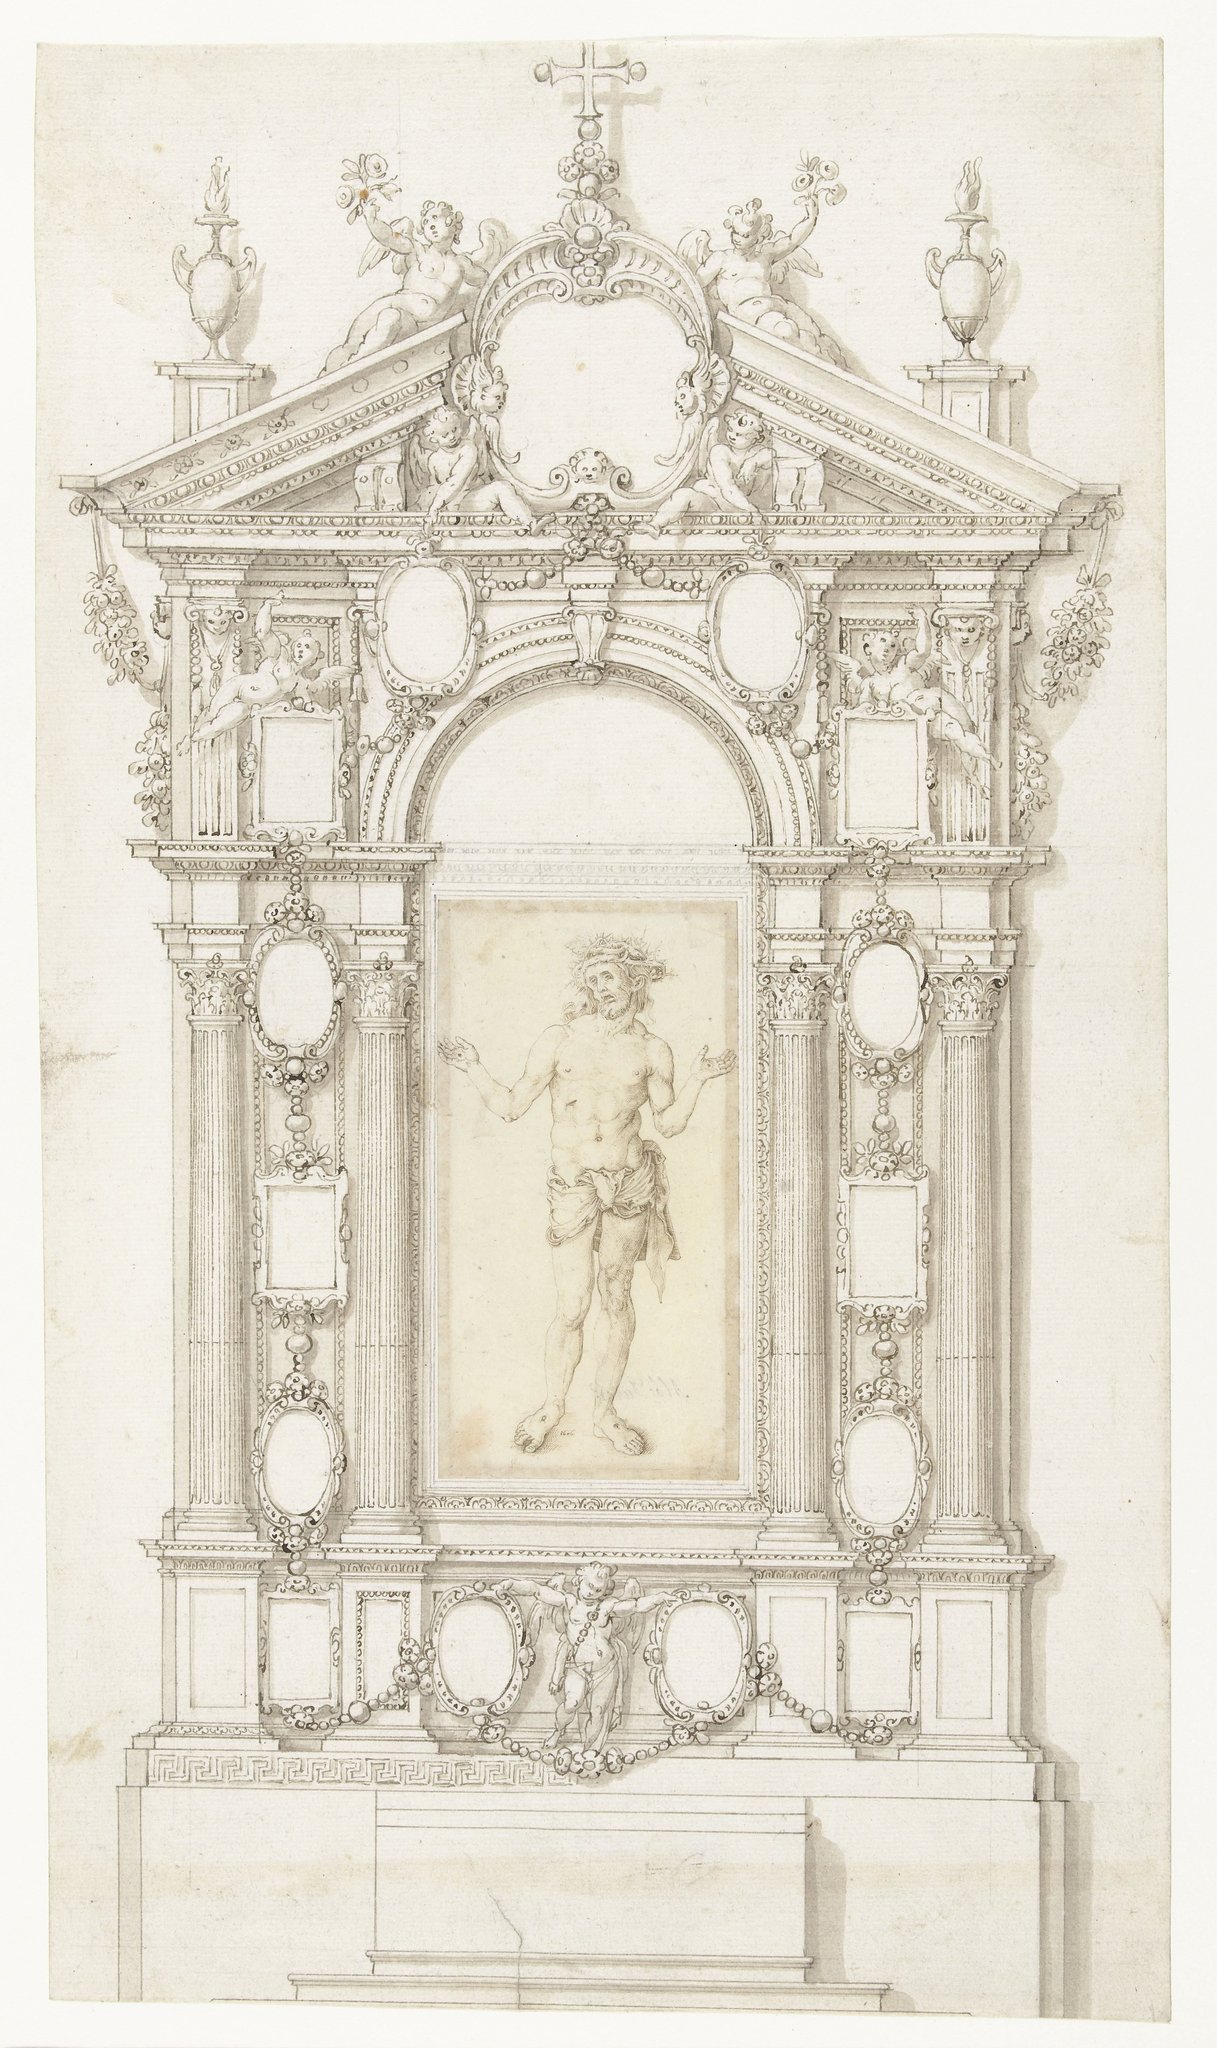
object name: drawing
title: Ornamentale lijst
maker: Anonymous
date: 1545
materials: paper